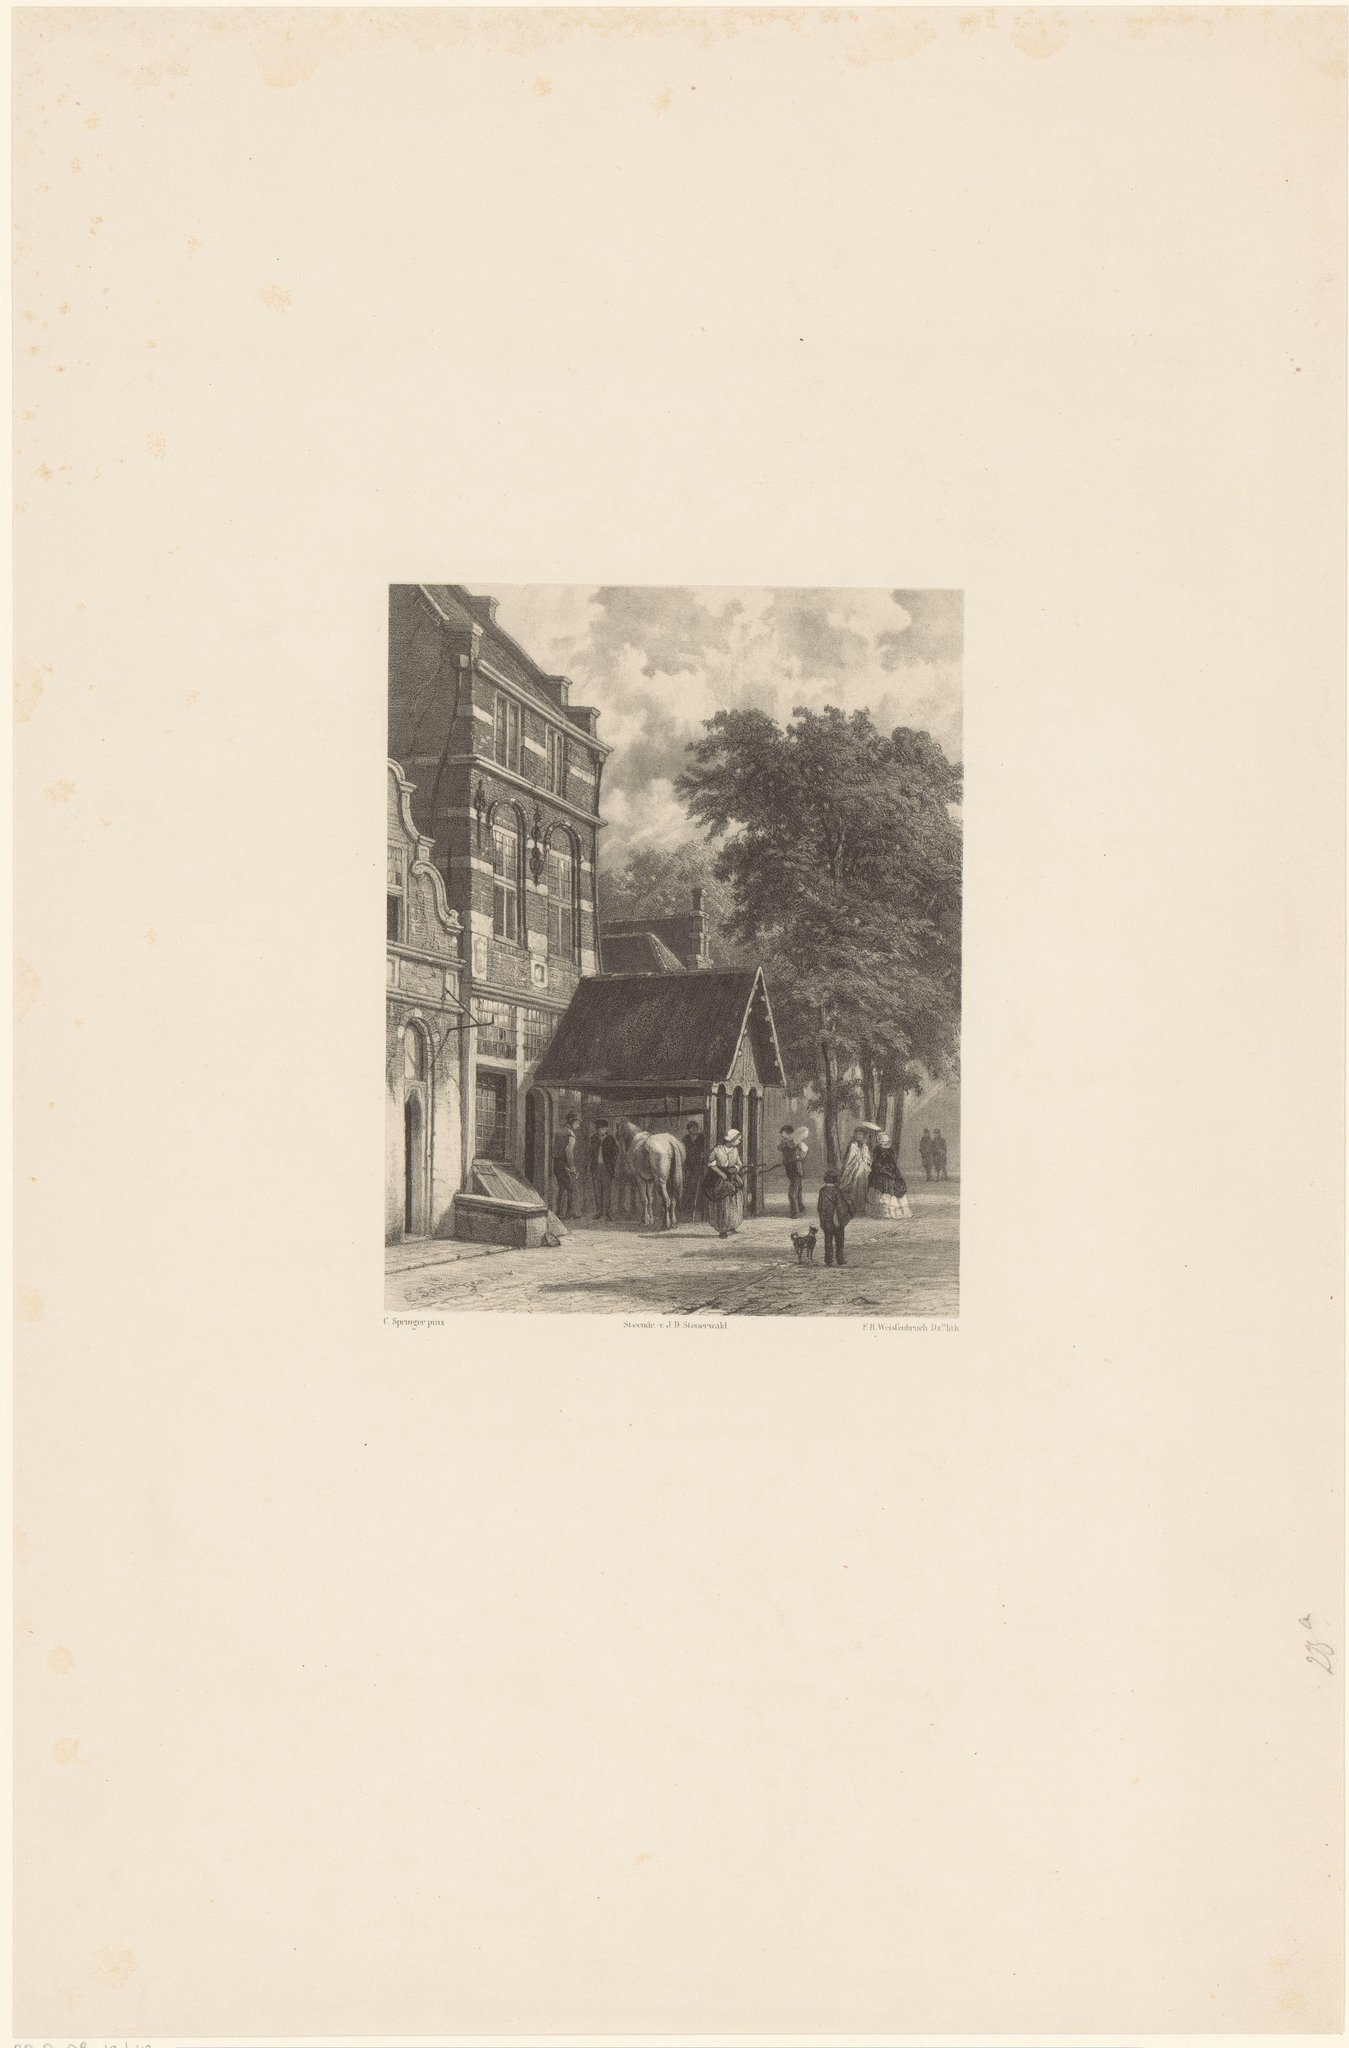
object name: print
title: Figuren op straat bij hoefsmid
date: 1838-1863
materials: paper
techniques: tone lithography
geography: the hague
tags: farrier, shoeing-smith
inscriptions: collector's mark: Lugt 2228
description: Een dorpsstraat met wandelende figuren en links figuren en een paard bij een hoefsmid.